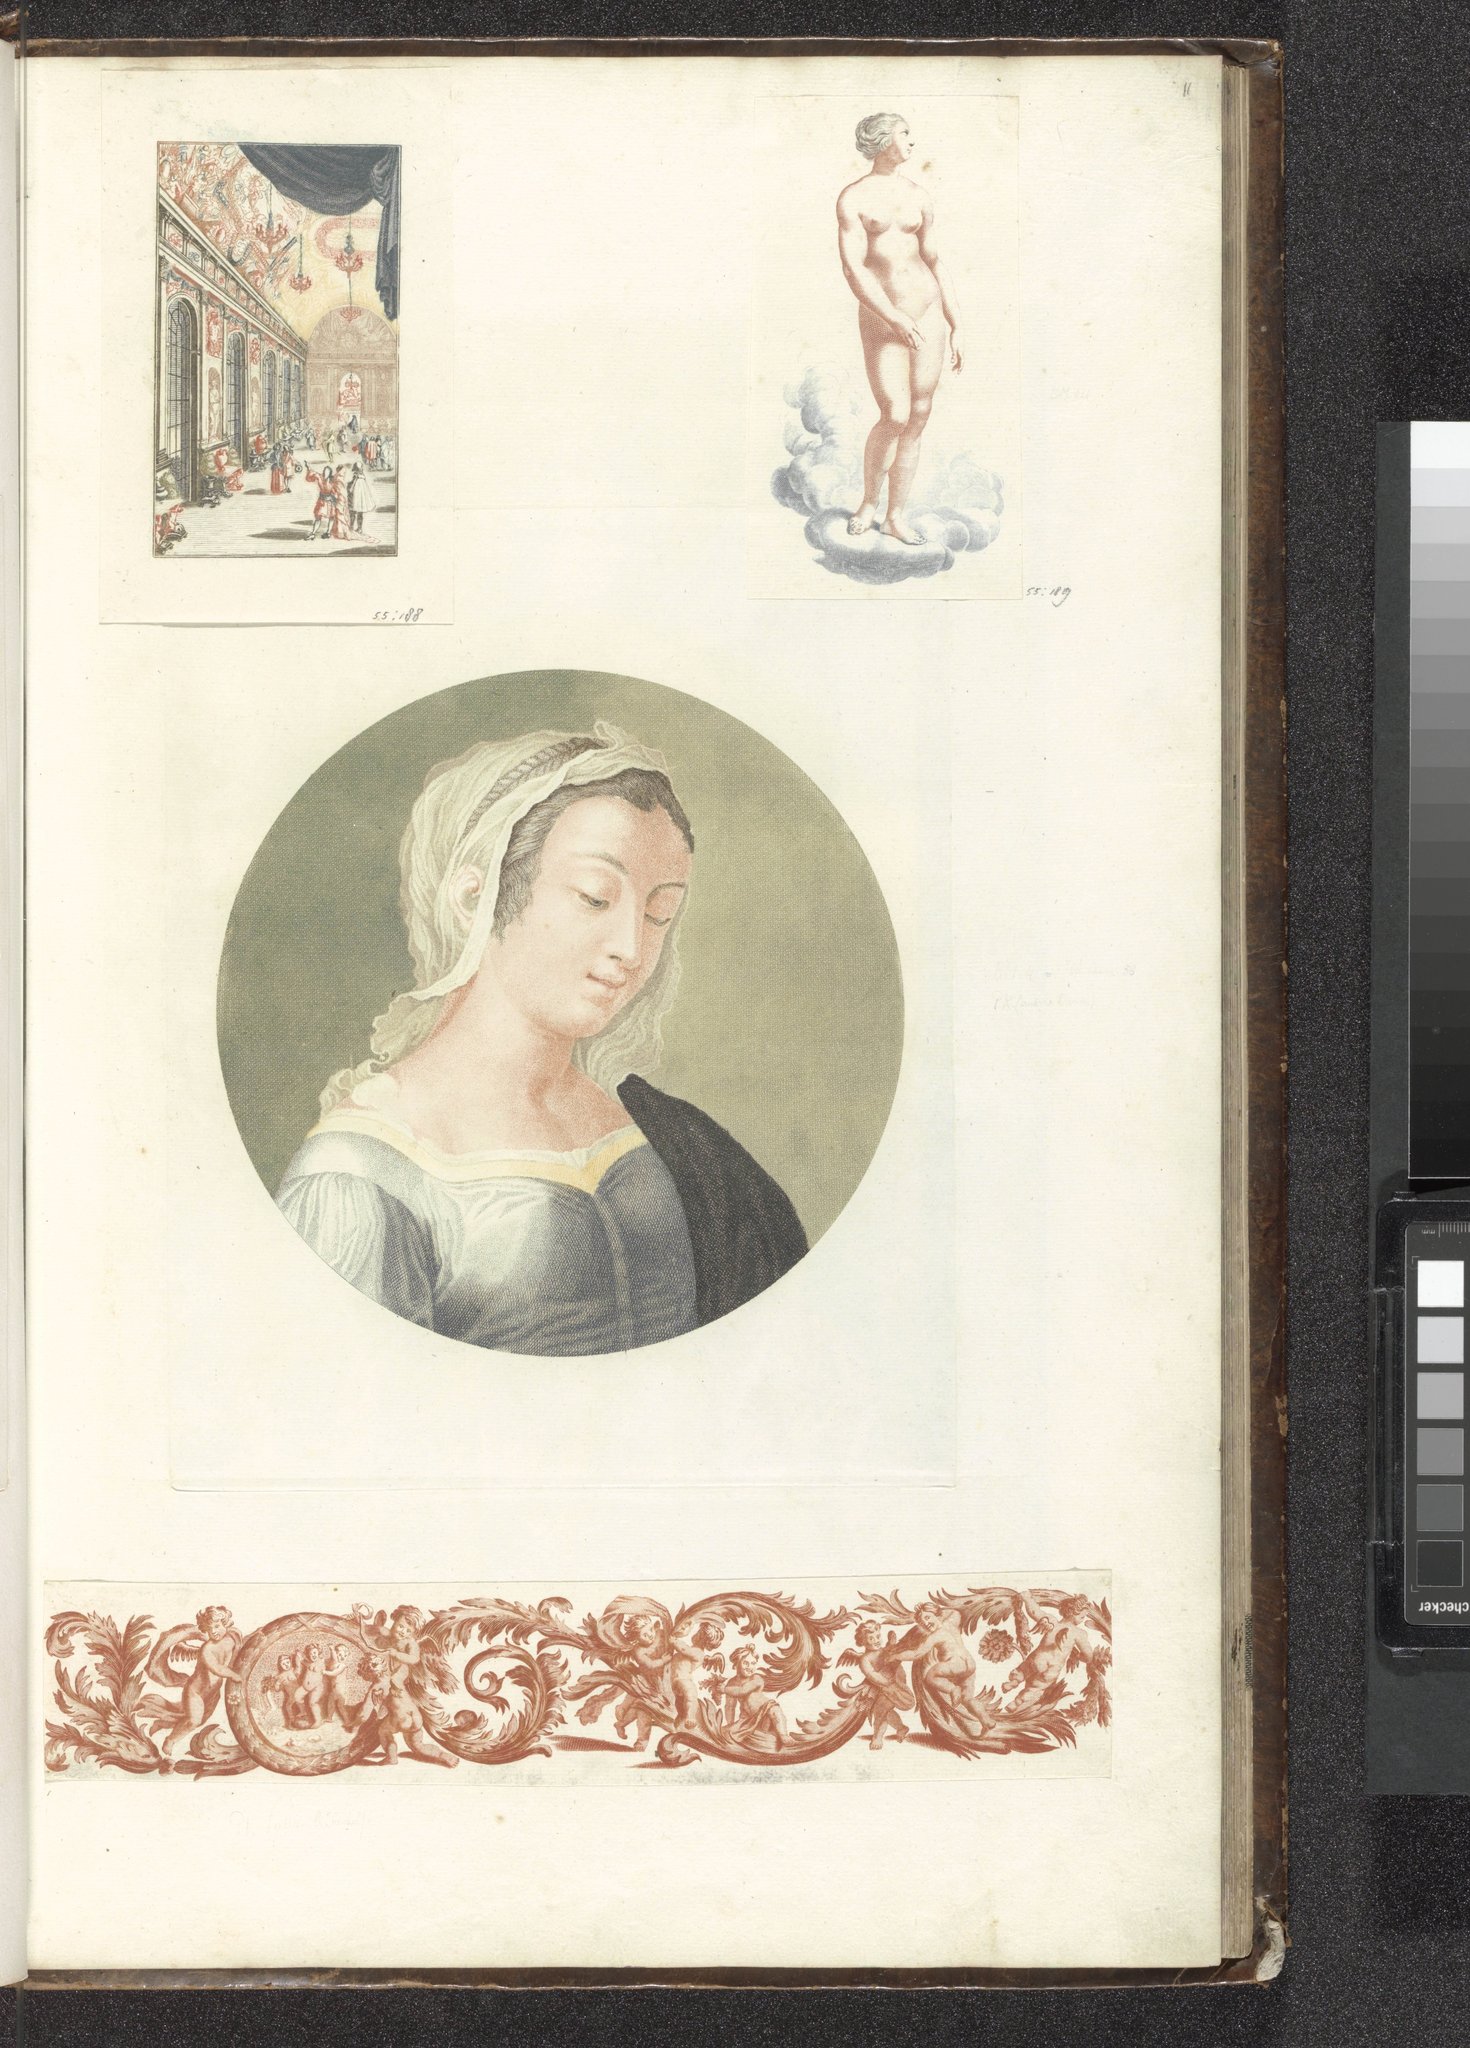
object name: print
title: Portret van een jonge vrouw met neergeslagen ogen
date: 1688-1698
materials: paper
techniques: etching, lithography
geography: netherlands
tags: chest, bust - aa - female human figure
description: Portret van een jonge vrouw met neergeslagen ogen en een sluier op het hoofd. Deze prent maakt deel uit van een album.